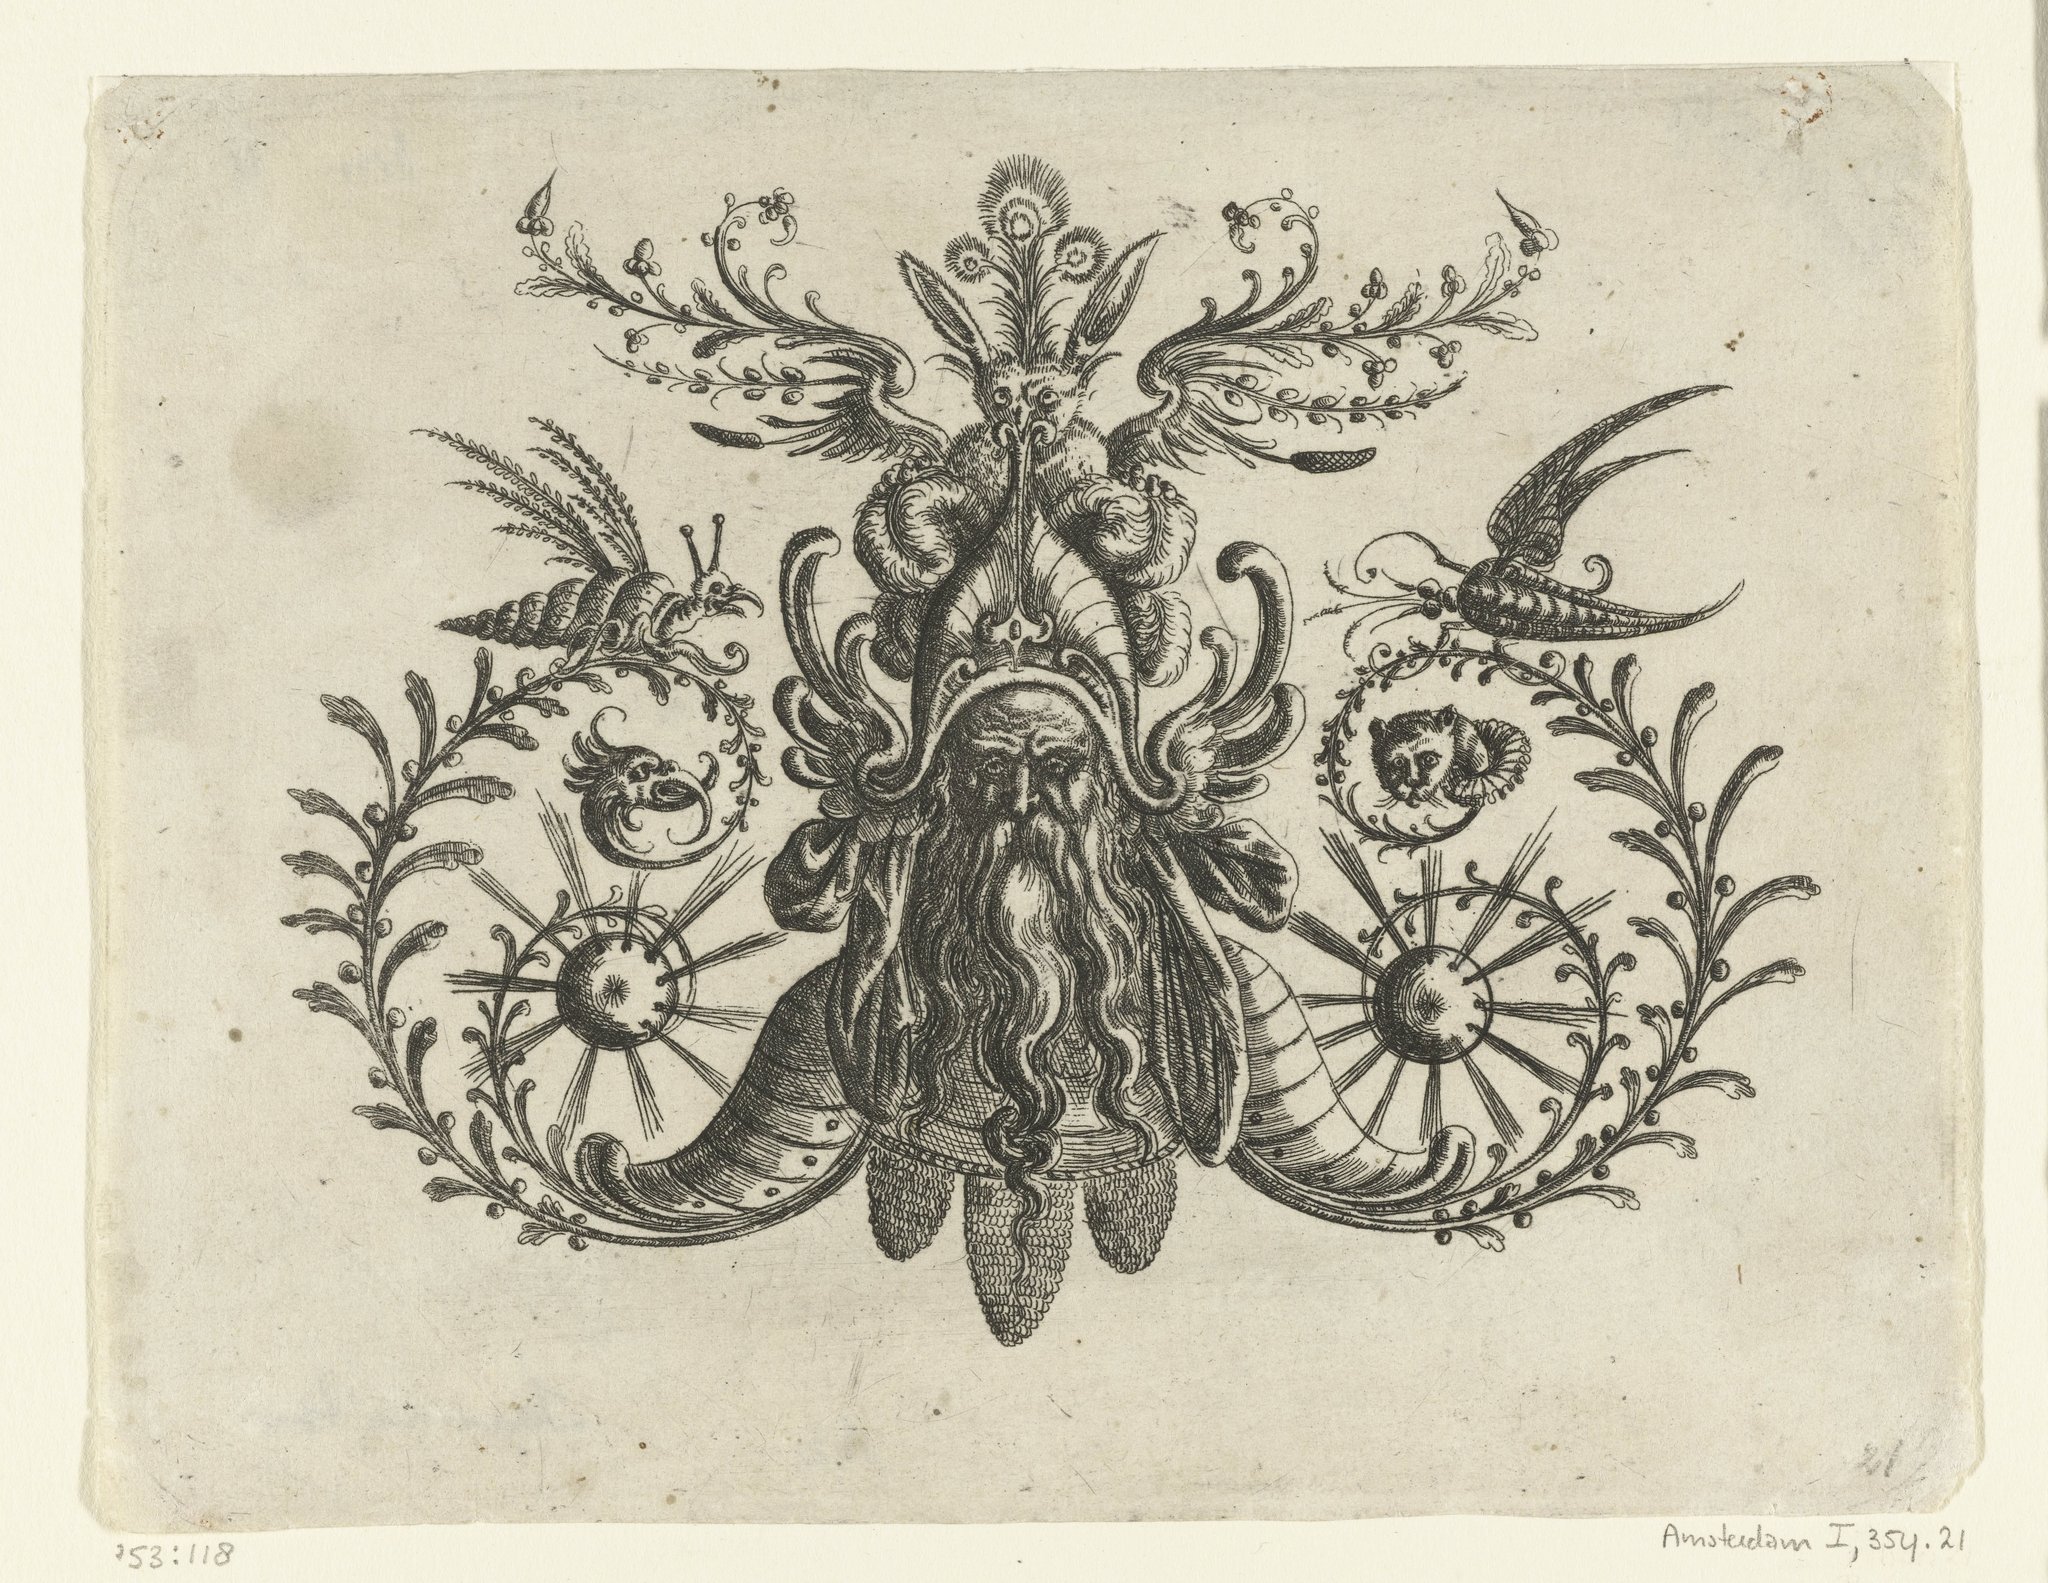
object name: ornament print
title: Das Neuw Grottesken Buch Nürnberg 1610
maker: christoph jamnitzer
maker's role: draughtsman, goldsmith, print maker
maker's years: 1563-1618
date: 1573-1610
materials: paper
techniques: etching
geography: germany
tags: mask, mascaron ~ ornament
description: De man heeft op zijn hoofd een helm waarop een konijn zit. Blad uit een serie vlakdecoraties met grotesken, cartouches, ovalen, mascarons, putti en fantastische wezens. De serie bestaat uit drie titelbladen, twee tekstbladen met de opdracht en het voorwoord en 60 bladen, verdeeld over drie boeken.